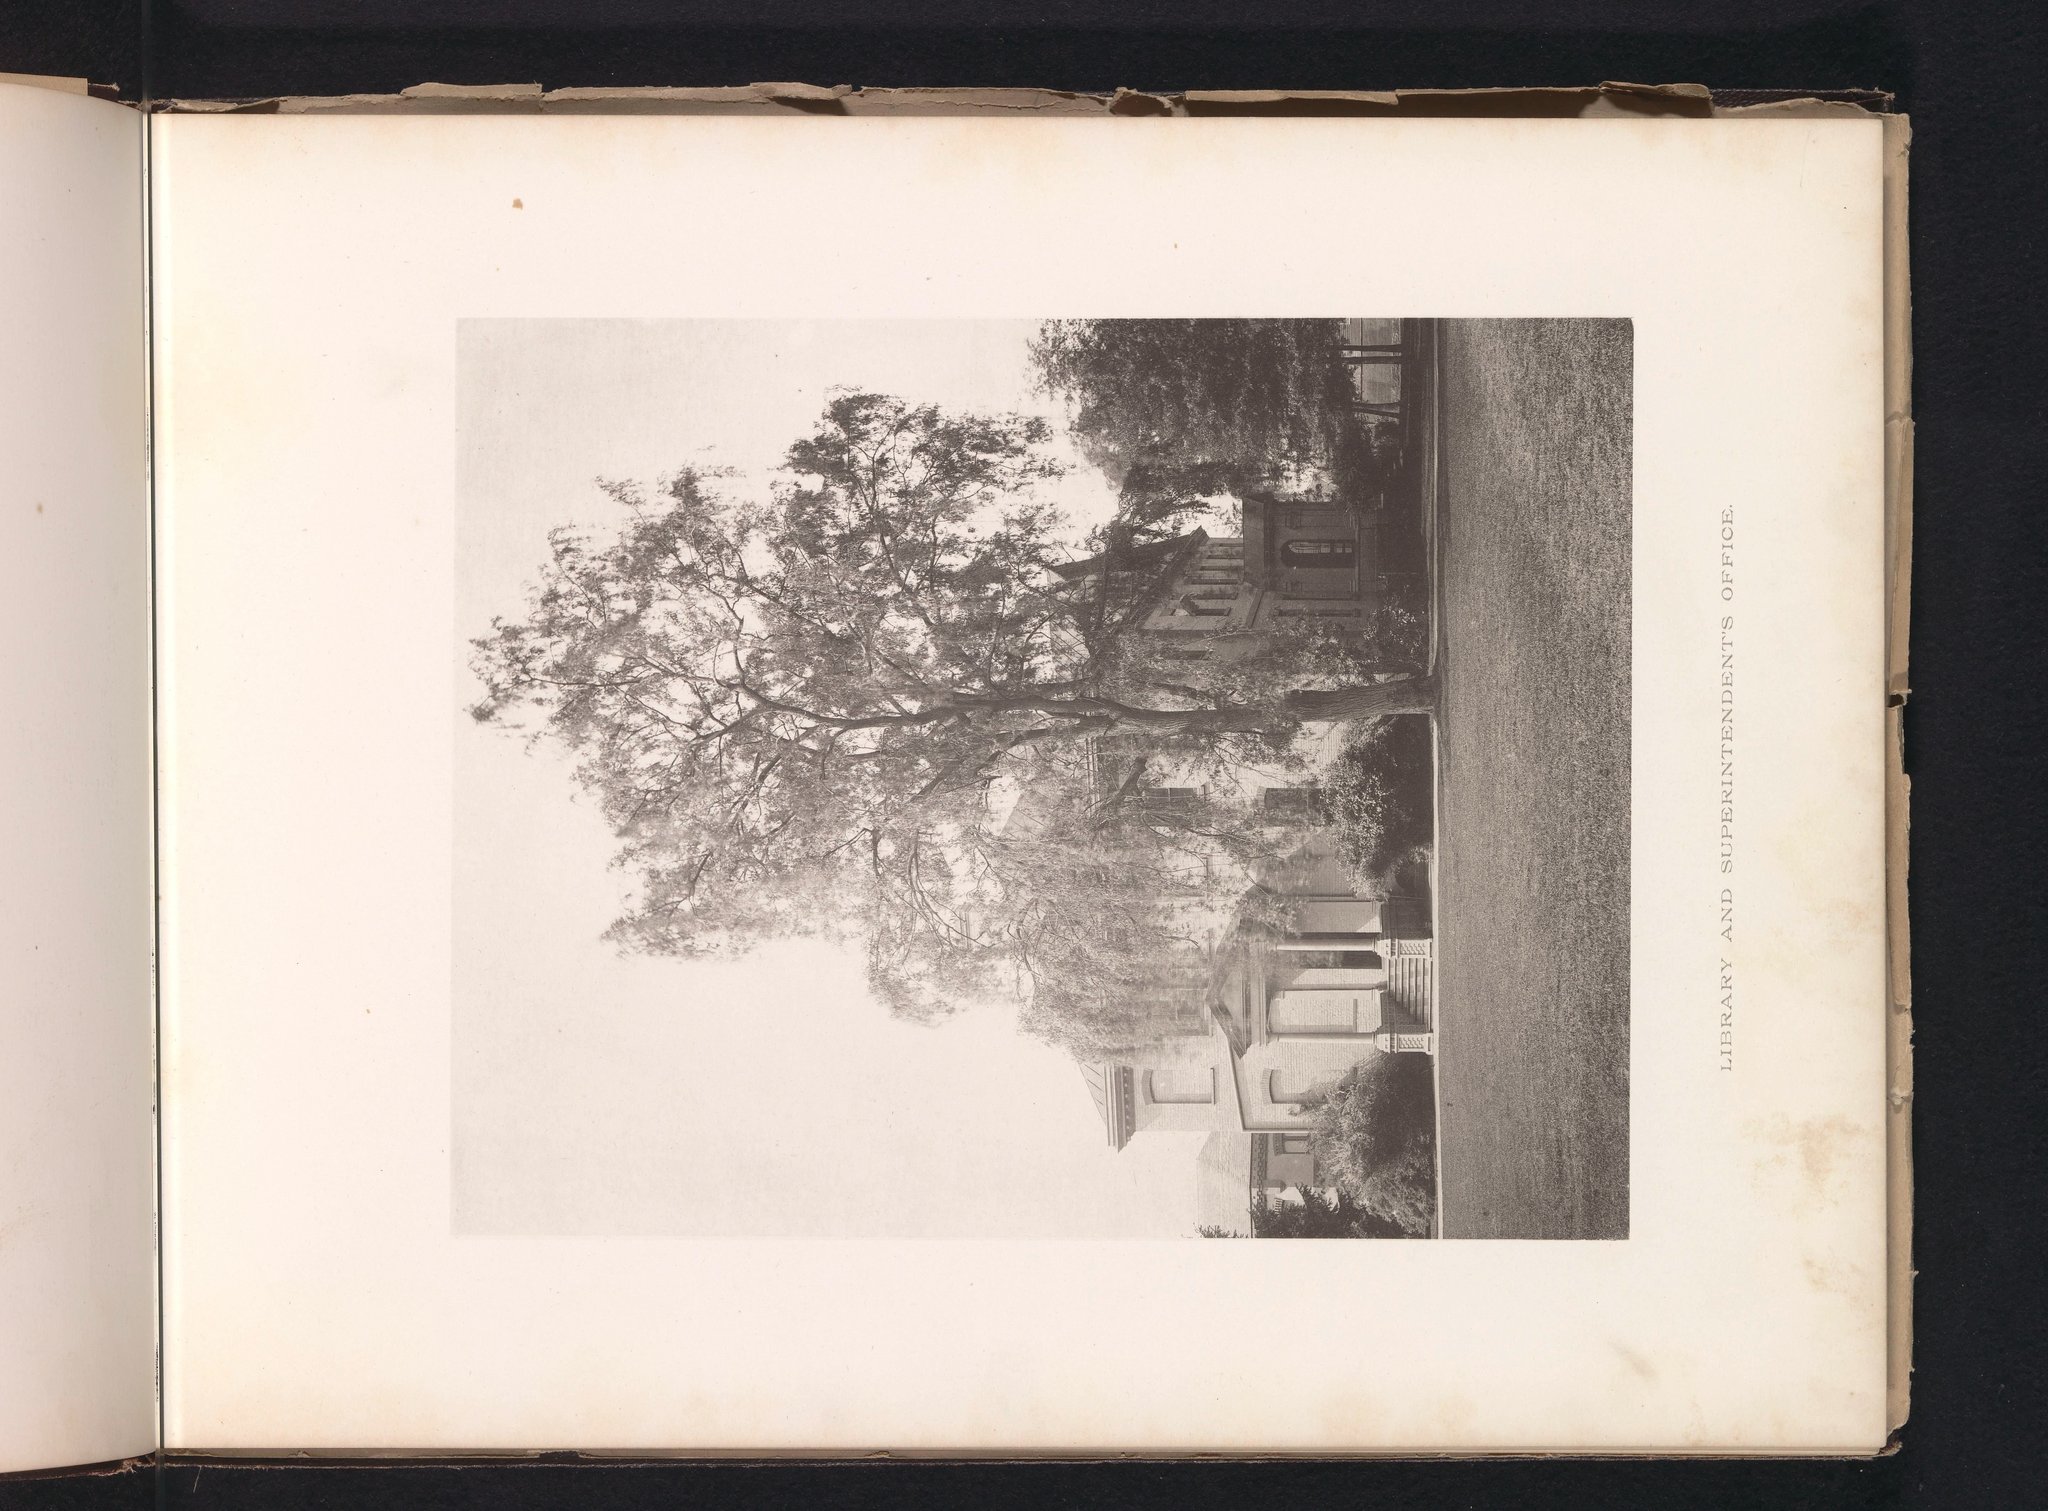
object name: page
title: Library and superintendent's office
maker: edward h. hart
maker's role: publisher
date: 1885-1890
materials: paper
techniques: photograph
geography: new york city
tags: military academy, façade (of house or building), public library